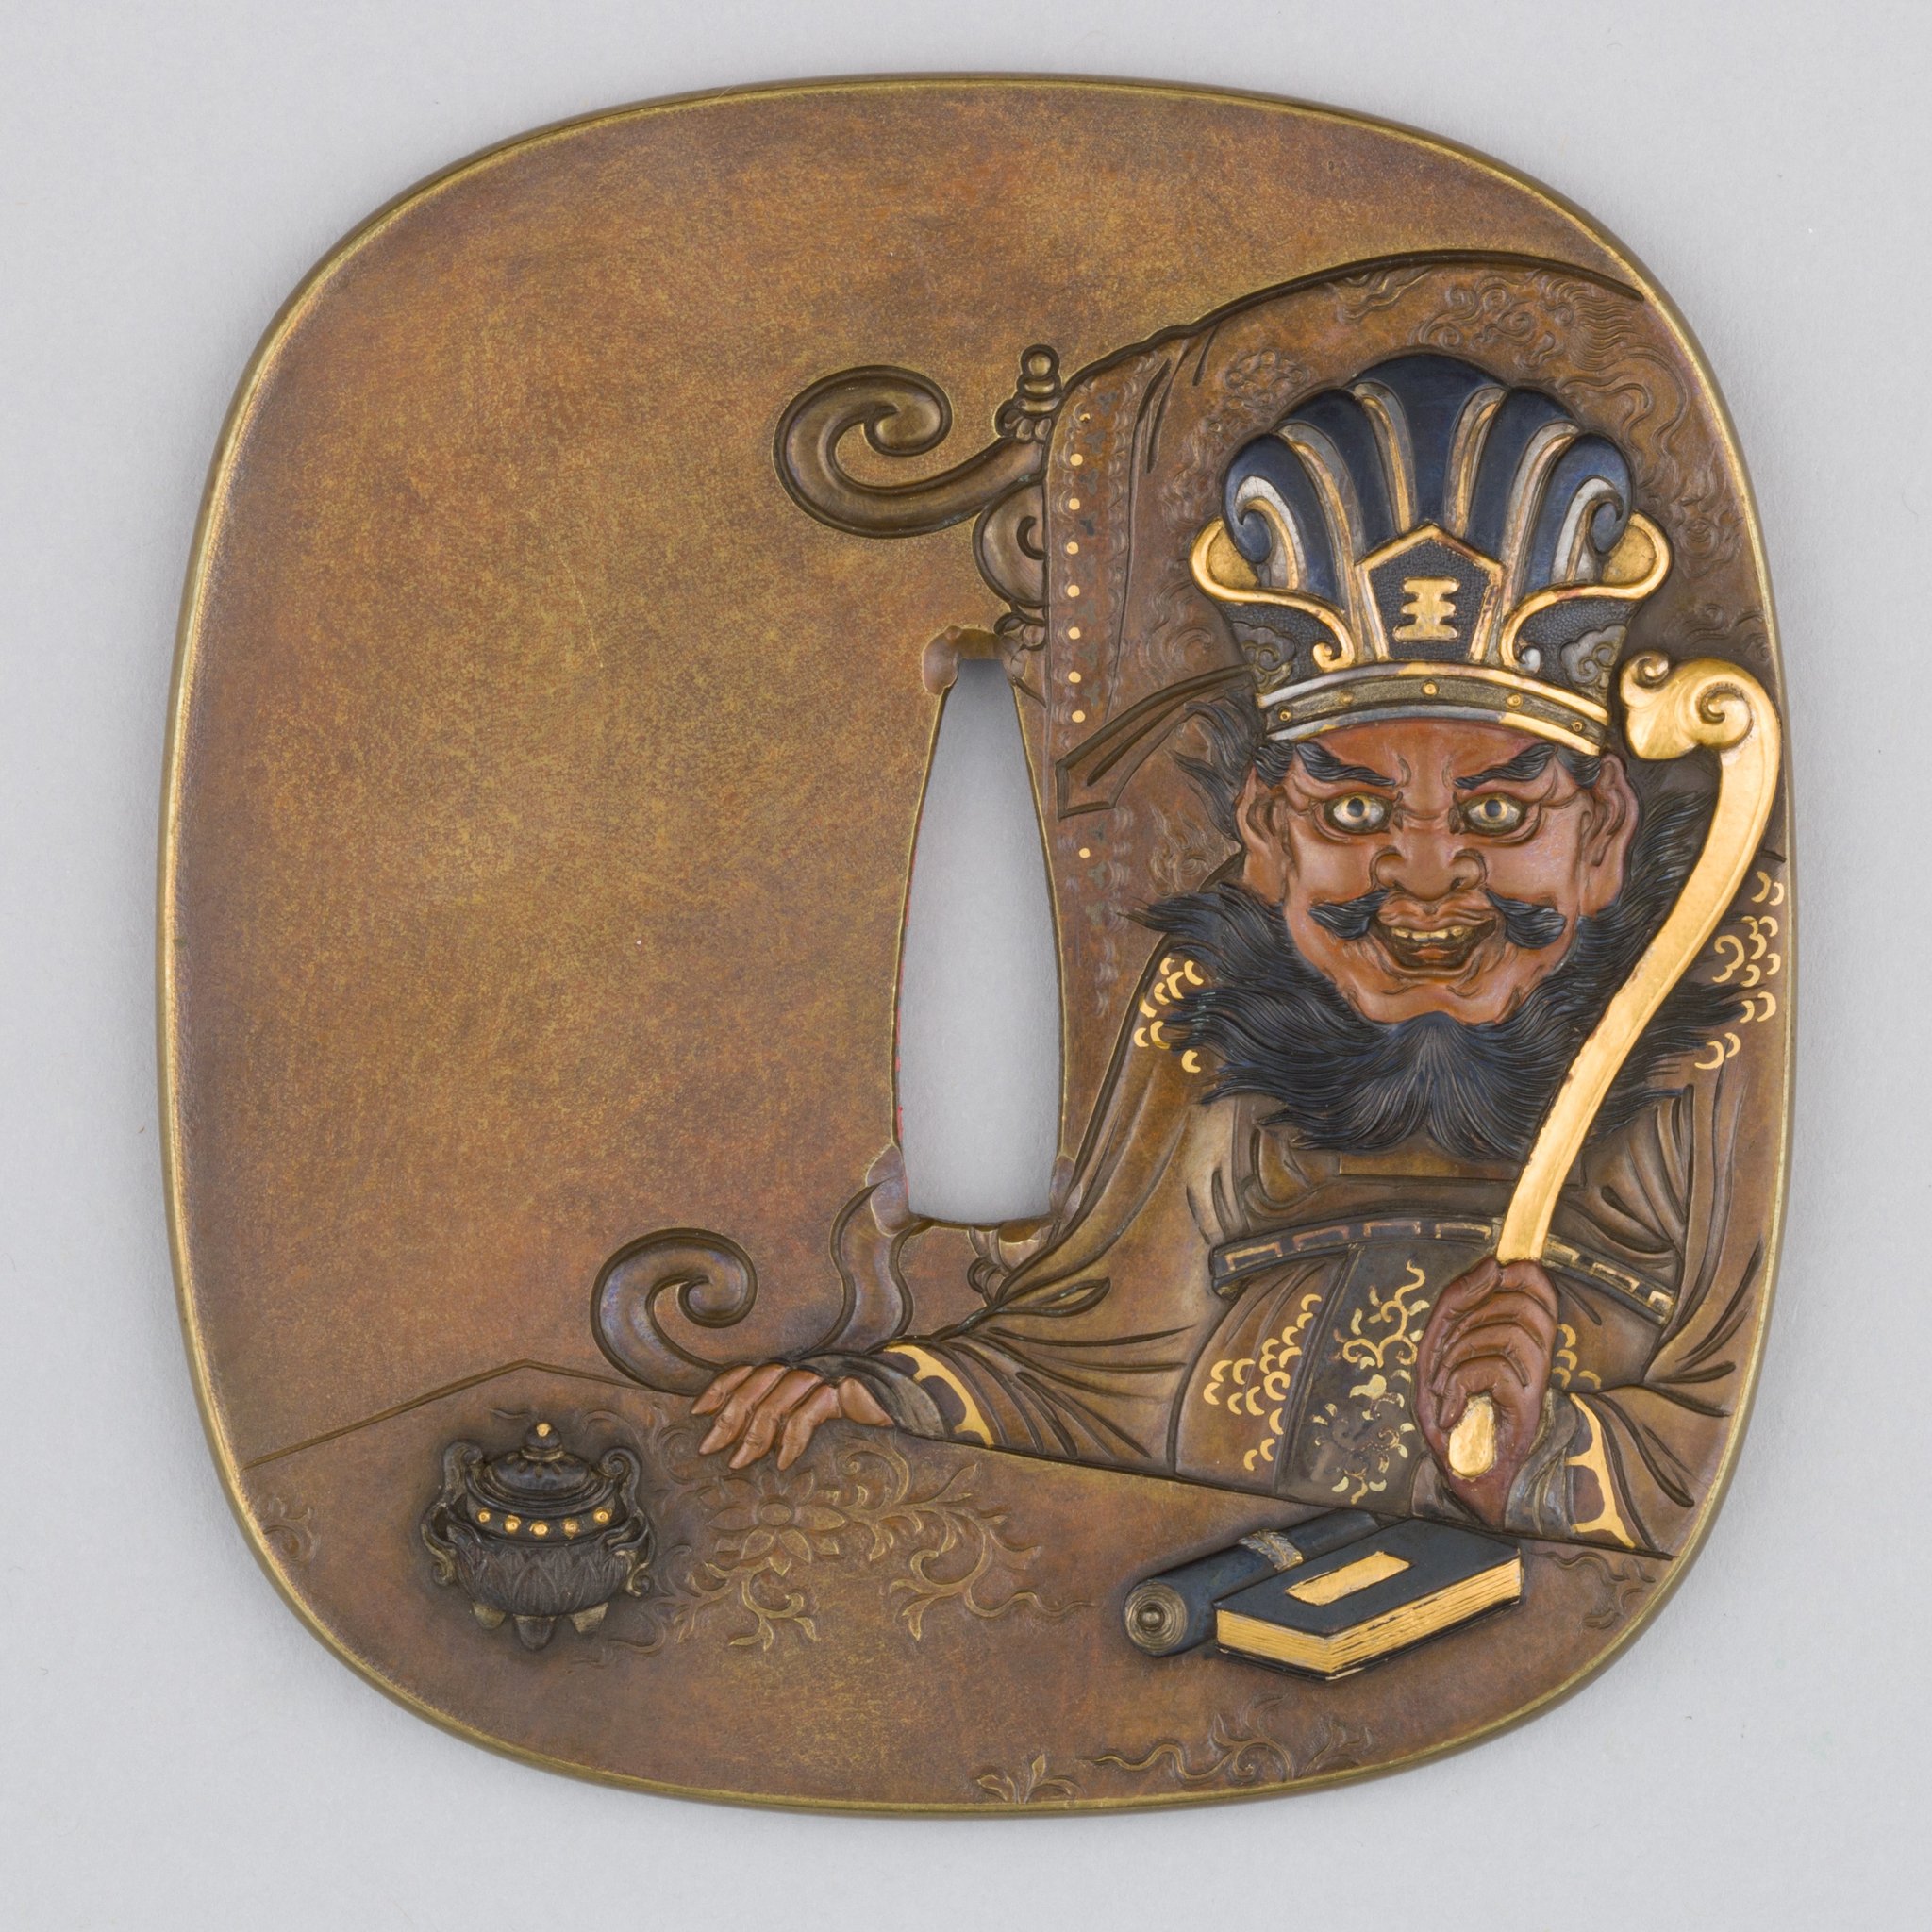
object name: sword guard tsuba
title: Sword Guard (Tsuba)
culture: japanese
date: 1615-1868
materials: copper, copper alloy, gold alloy, gold, silver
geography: japan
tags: men